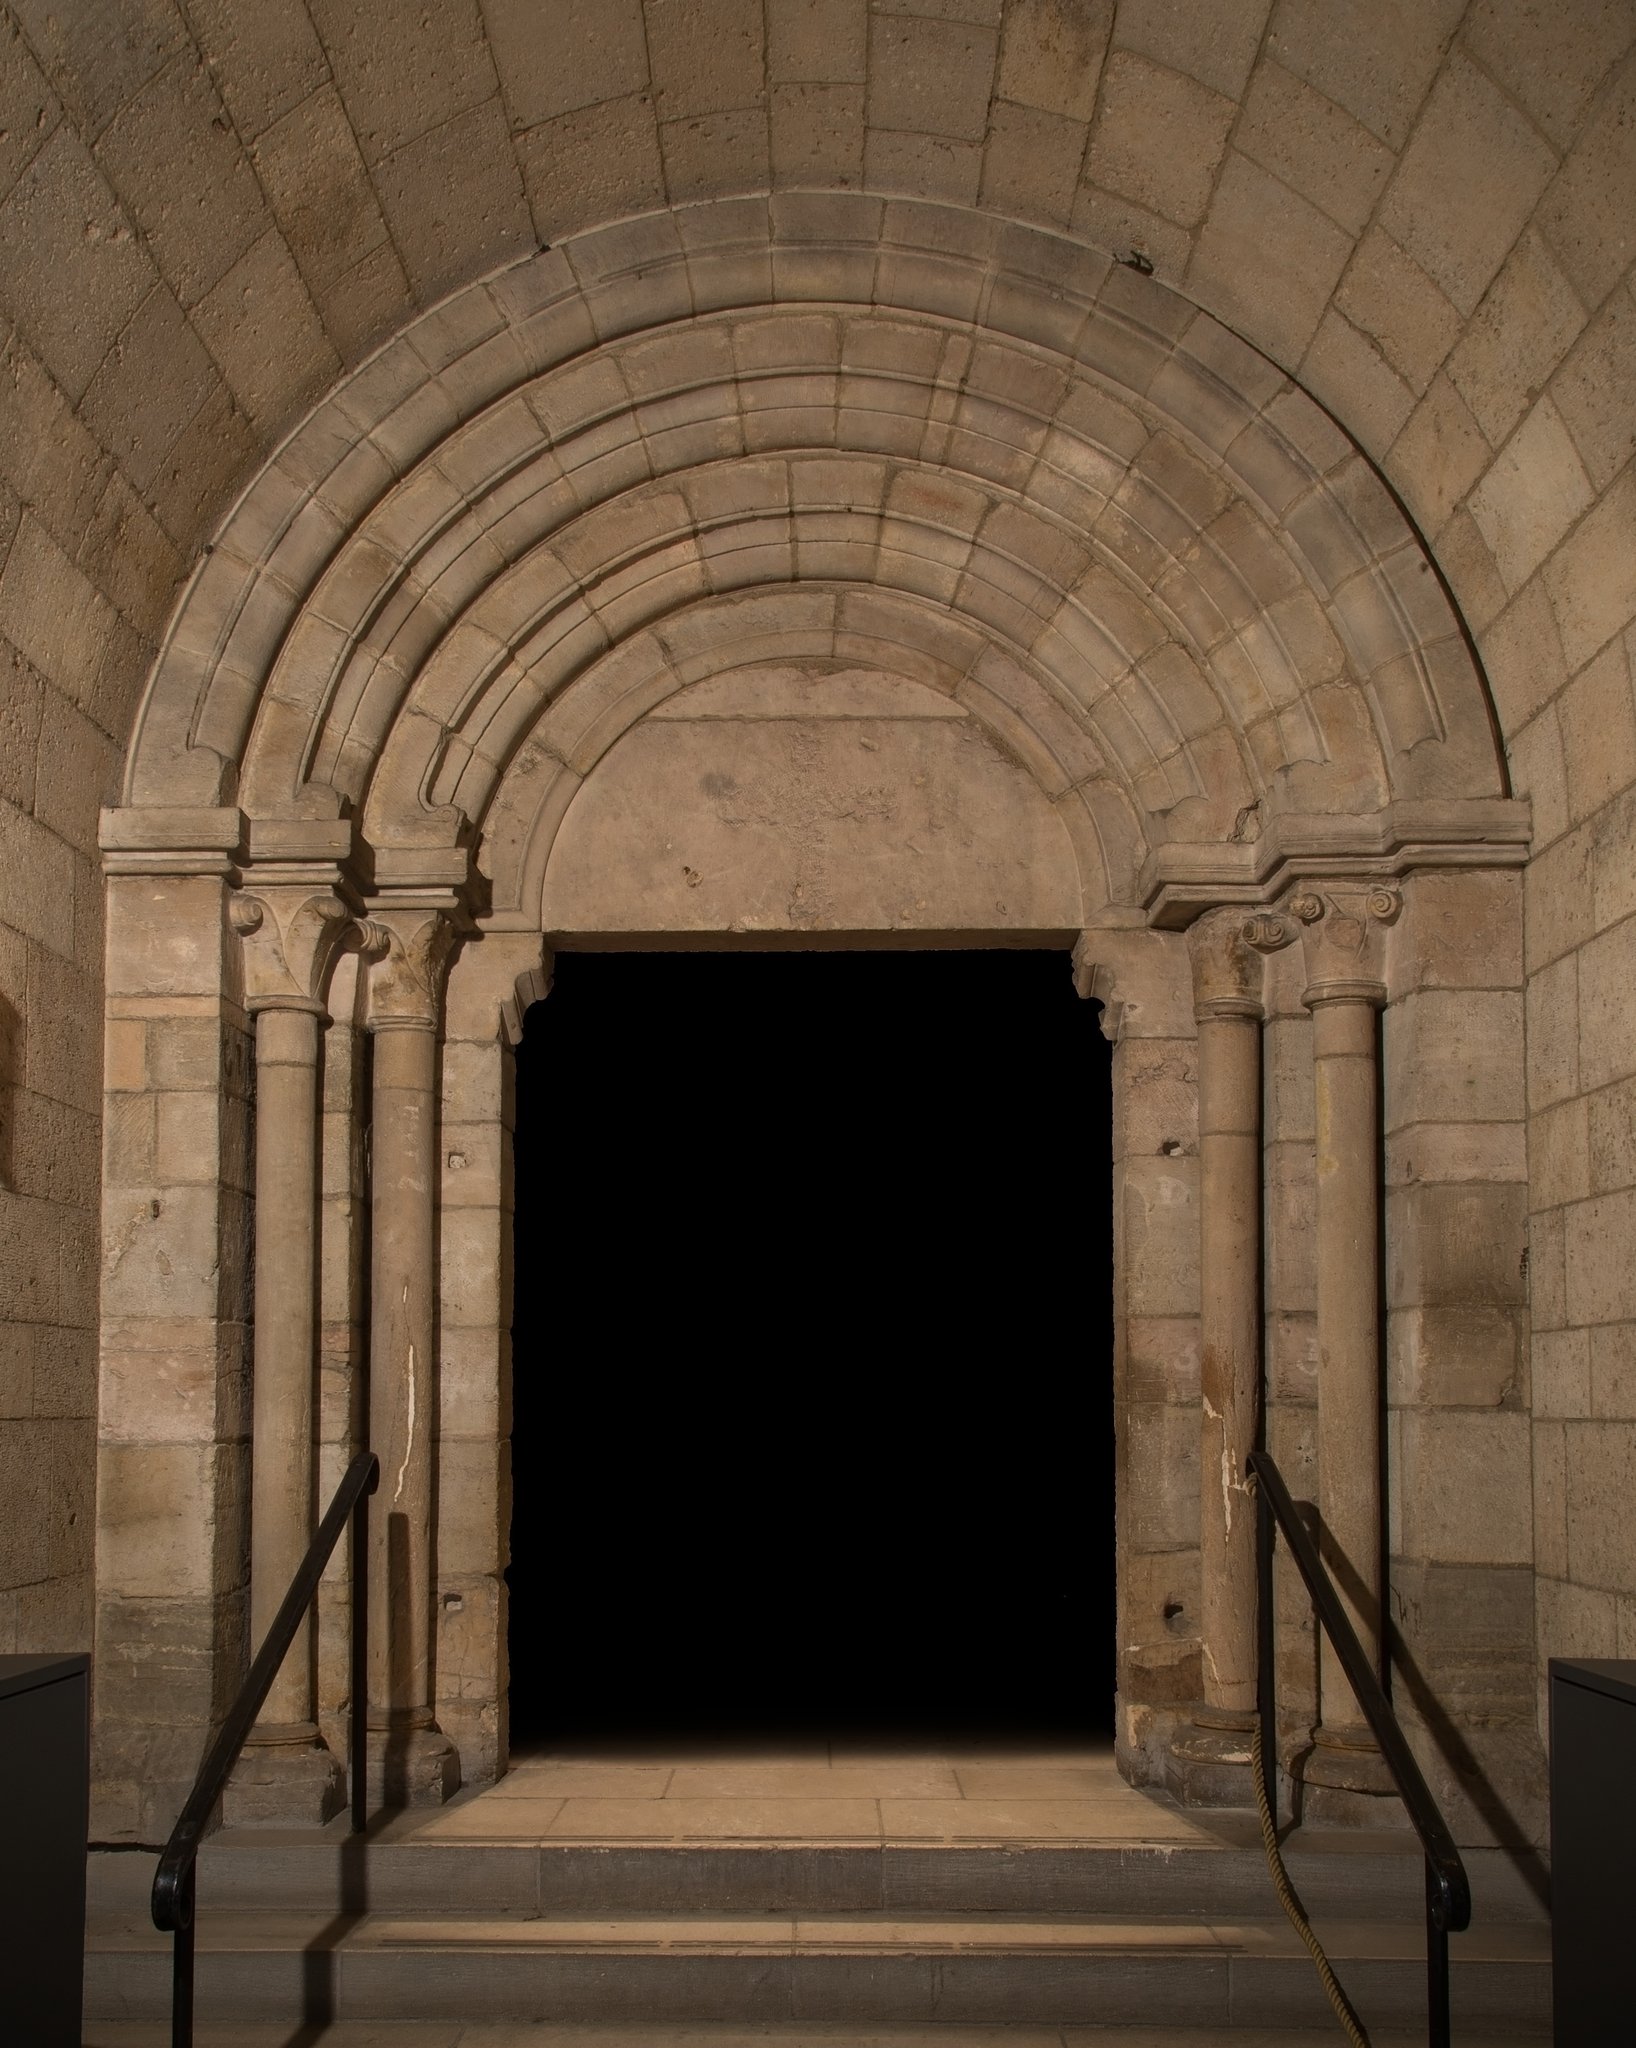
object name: doorway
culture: french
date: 1101-1200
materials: limestone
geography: france